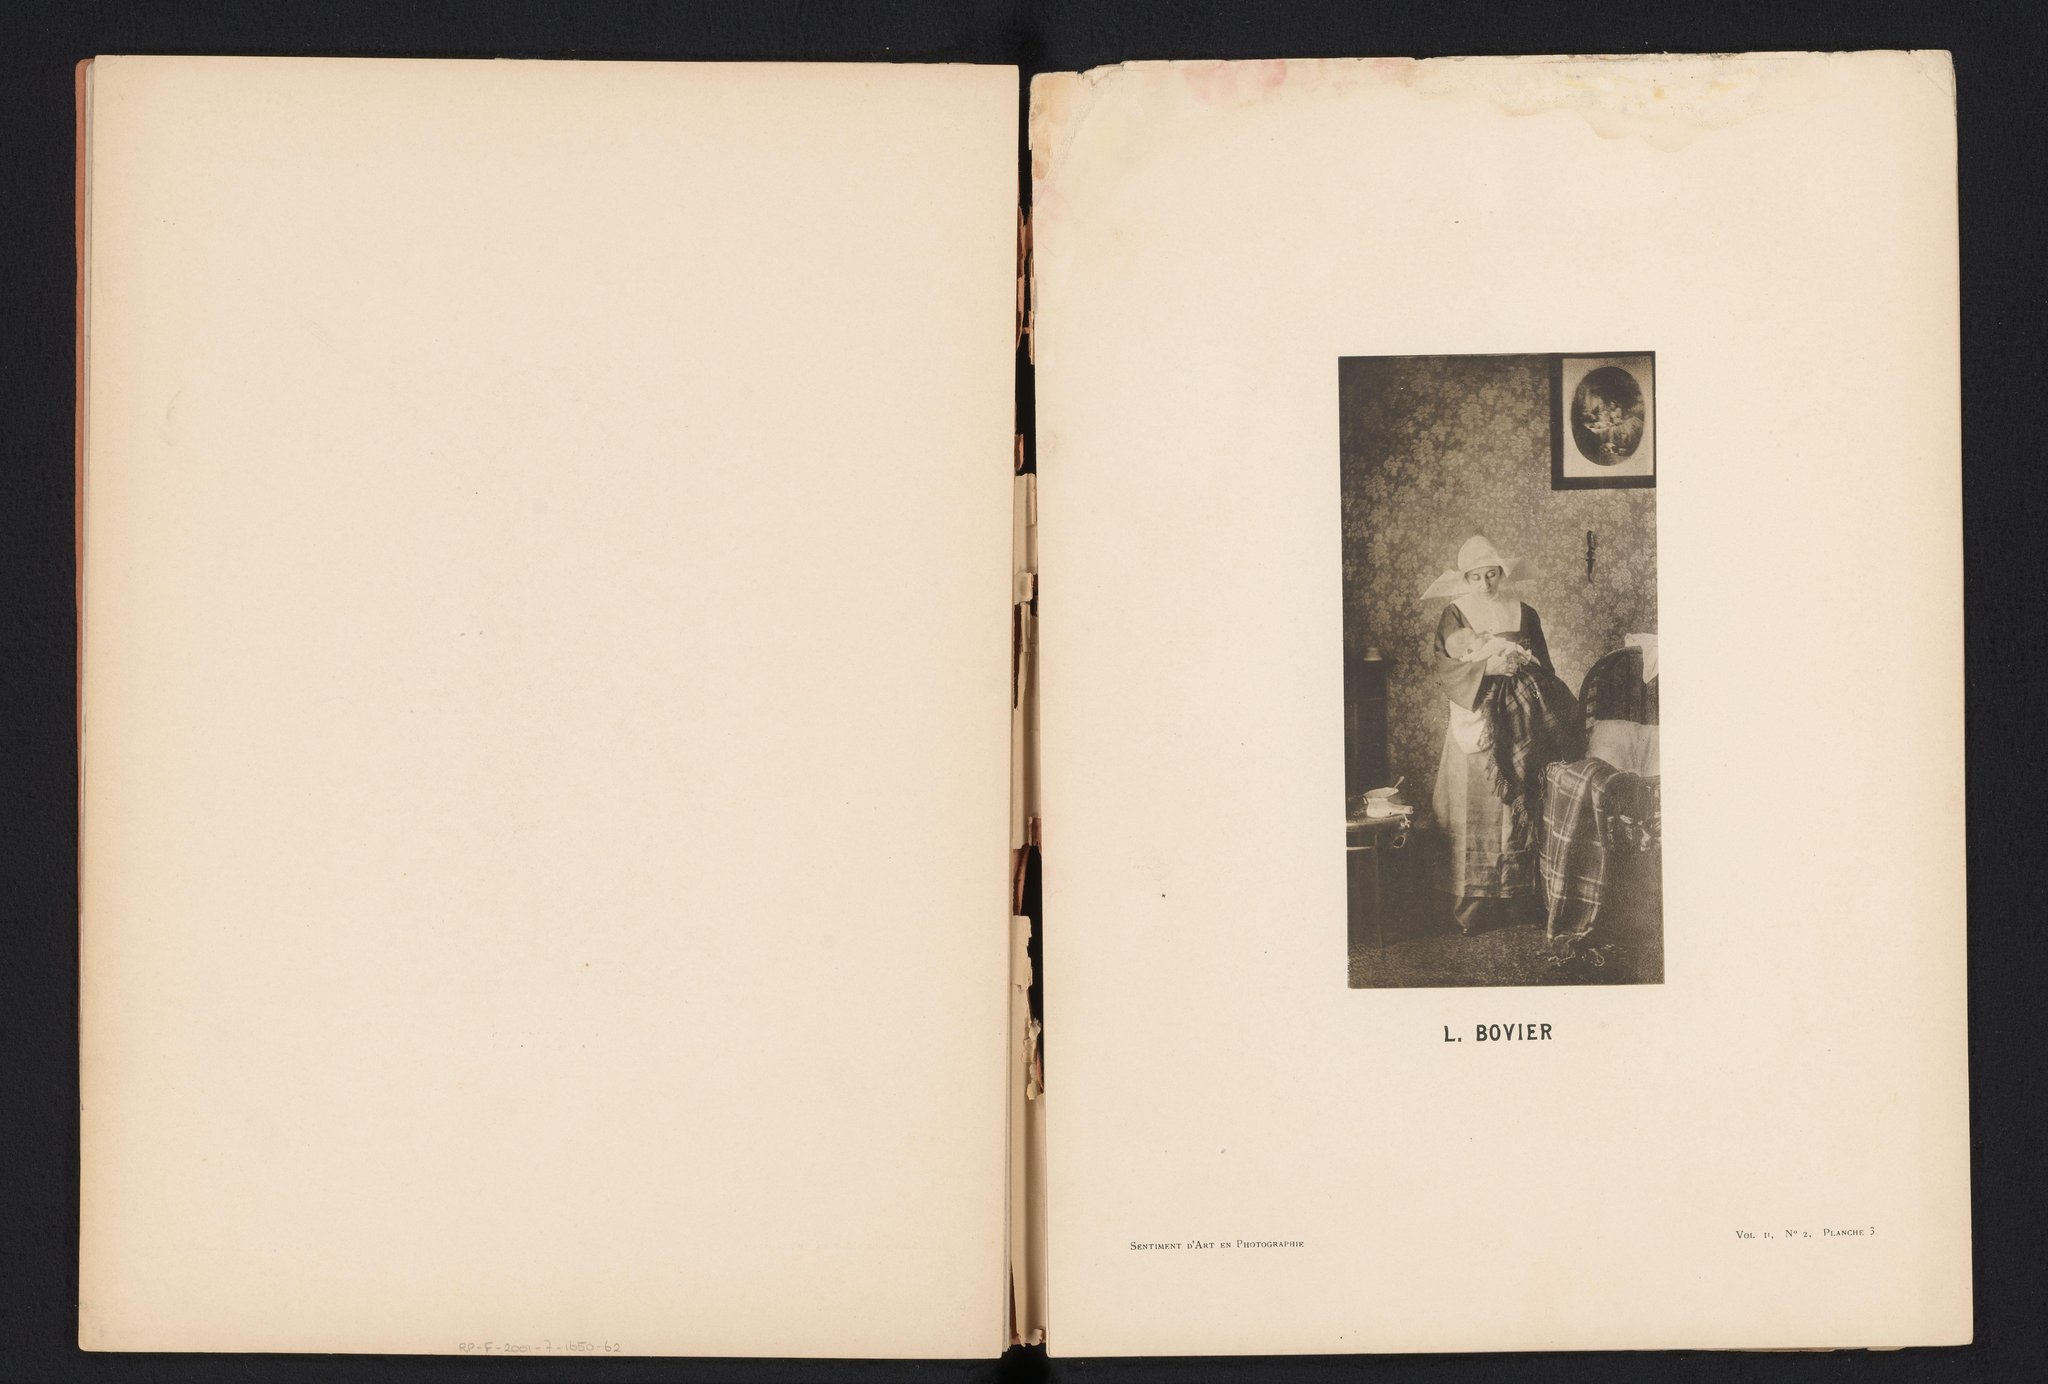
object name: photomechanical print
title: Vrouw met een baby op haar arm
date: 1895-1900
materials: paper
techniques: photograph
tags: adult woman, infant, baby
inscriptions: number: ‘Vol. II, No 2, Planche 3.’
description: Deze prent maakt deel uit van 8 omslagen met 22 tekstbladen en 89 prenten op losse bladen in en tussen de omslagen.